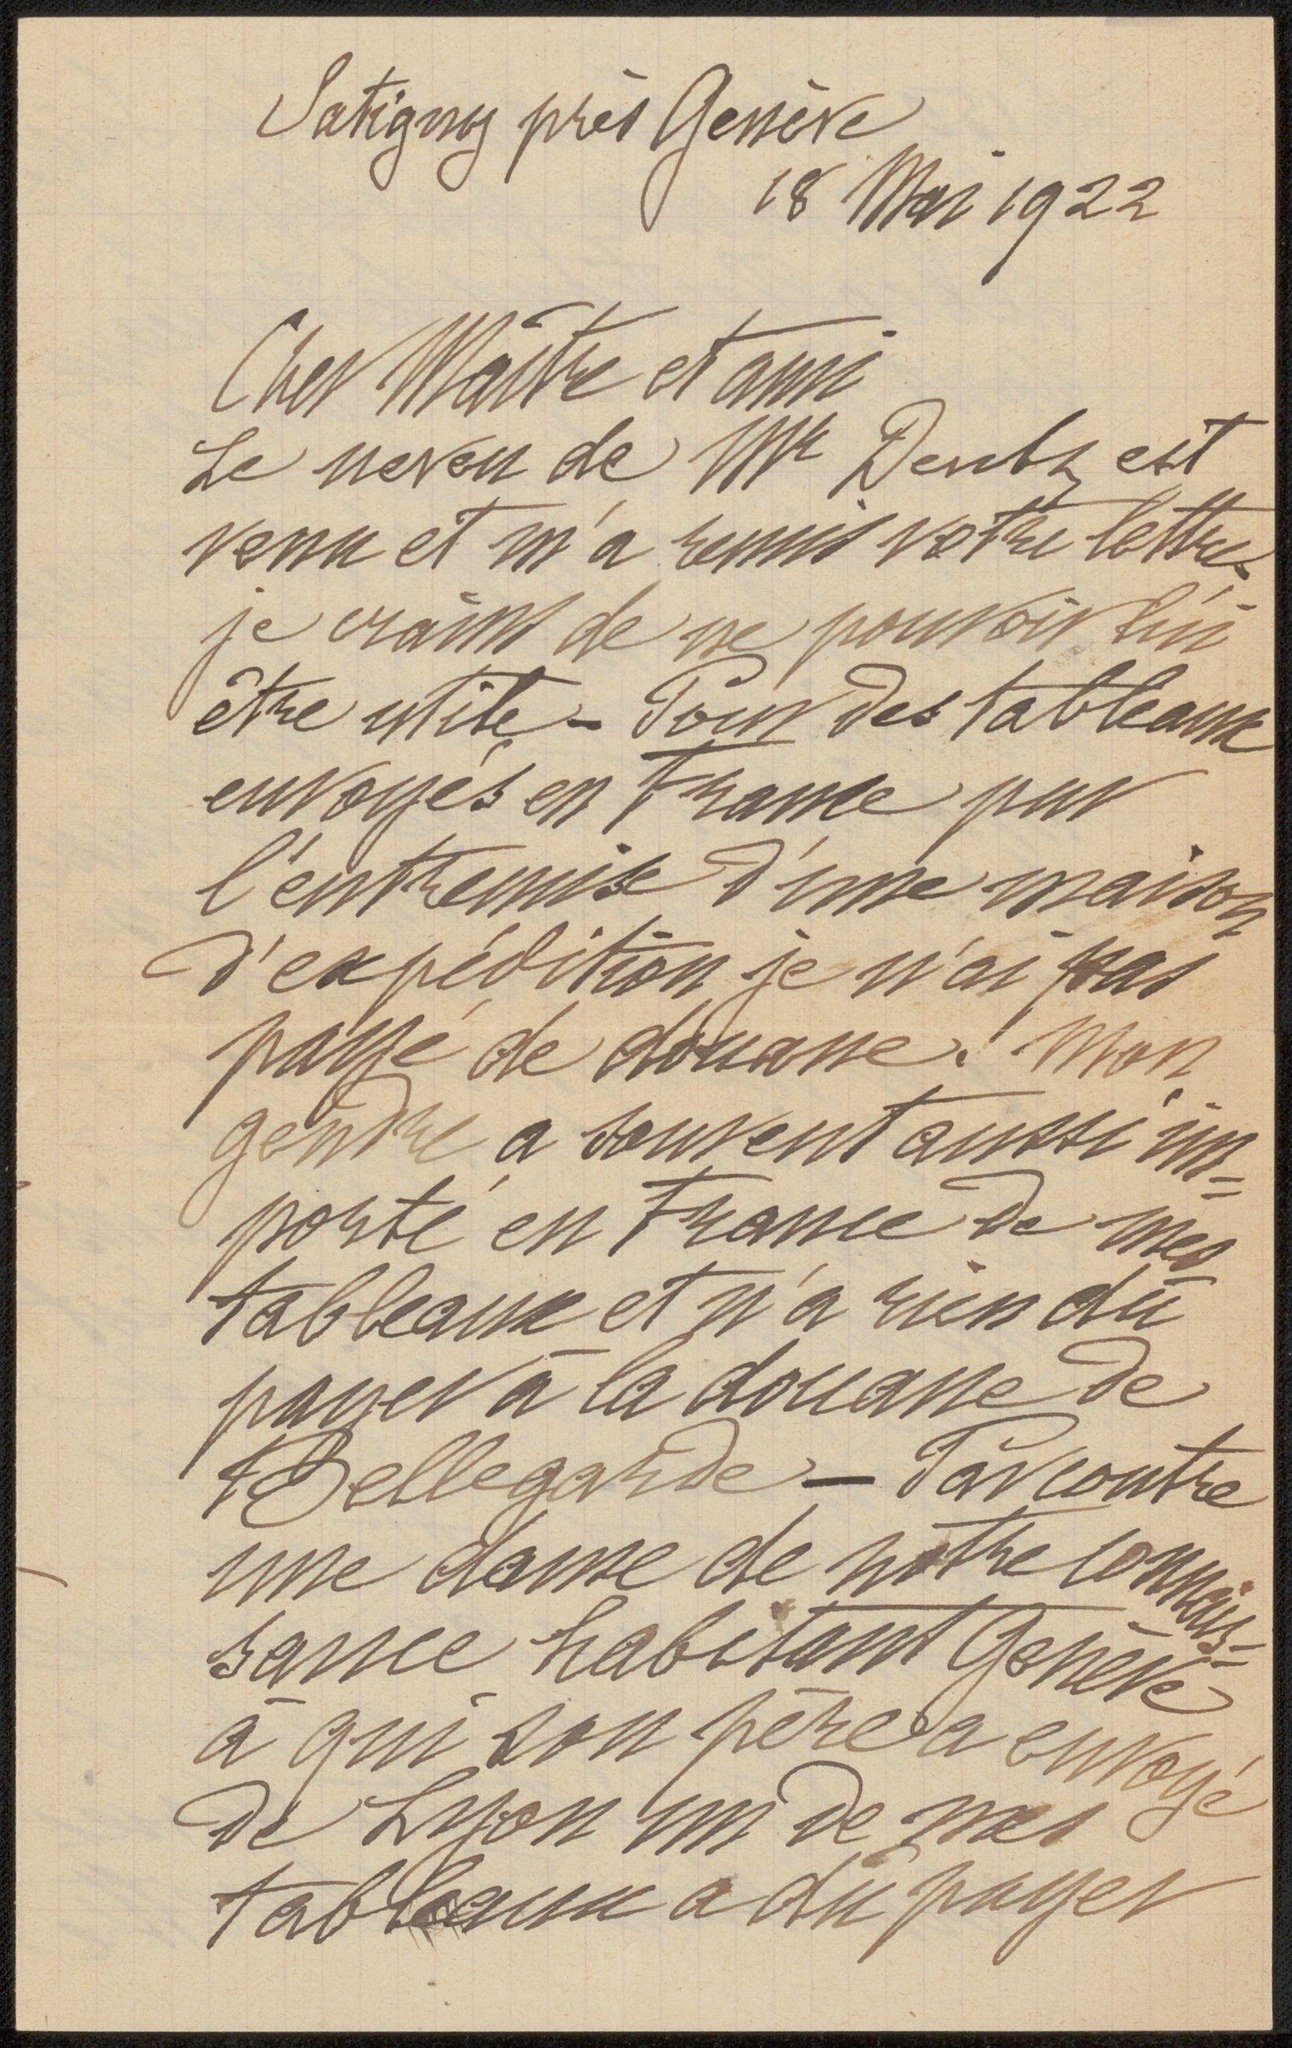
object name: letter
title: Brief aan Philip Zilcken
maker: alphonse stengelin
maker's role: painter, print maker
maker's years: 1852-1938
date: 1922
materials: ink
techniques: pen, writing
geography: satigny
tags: utrecht, draughtsman, philip zilcken, drawing, painting (including book-illumination, miniature-painting), money, france, switzerland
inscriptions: collector's mark: ‘RPK’